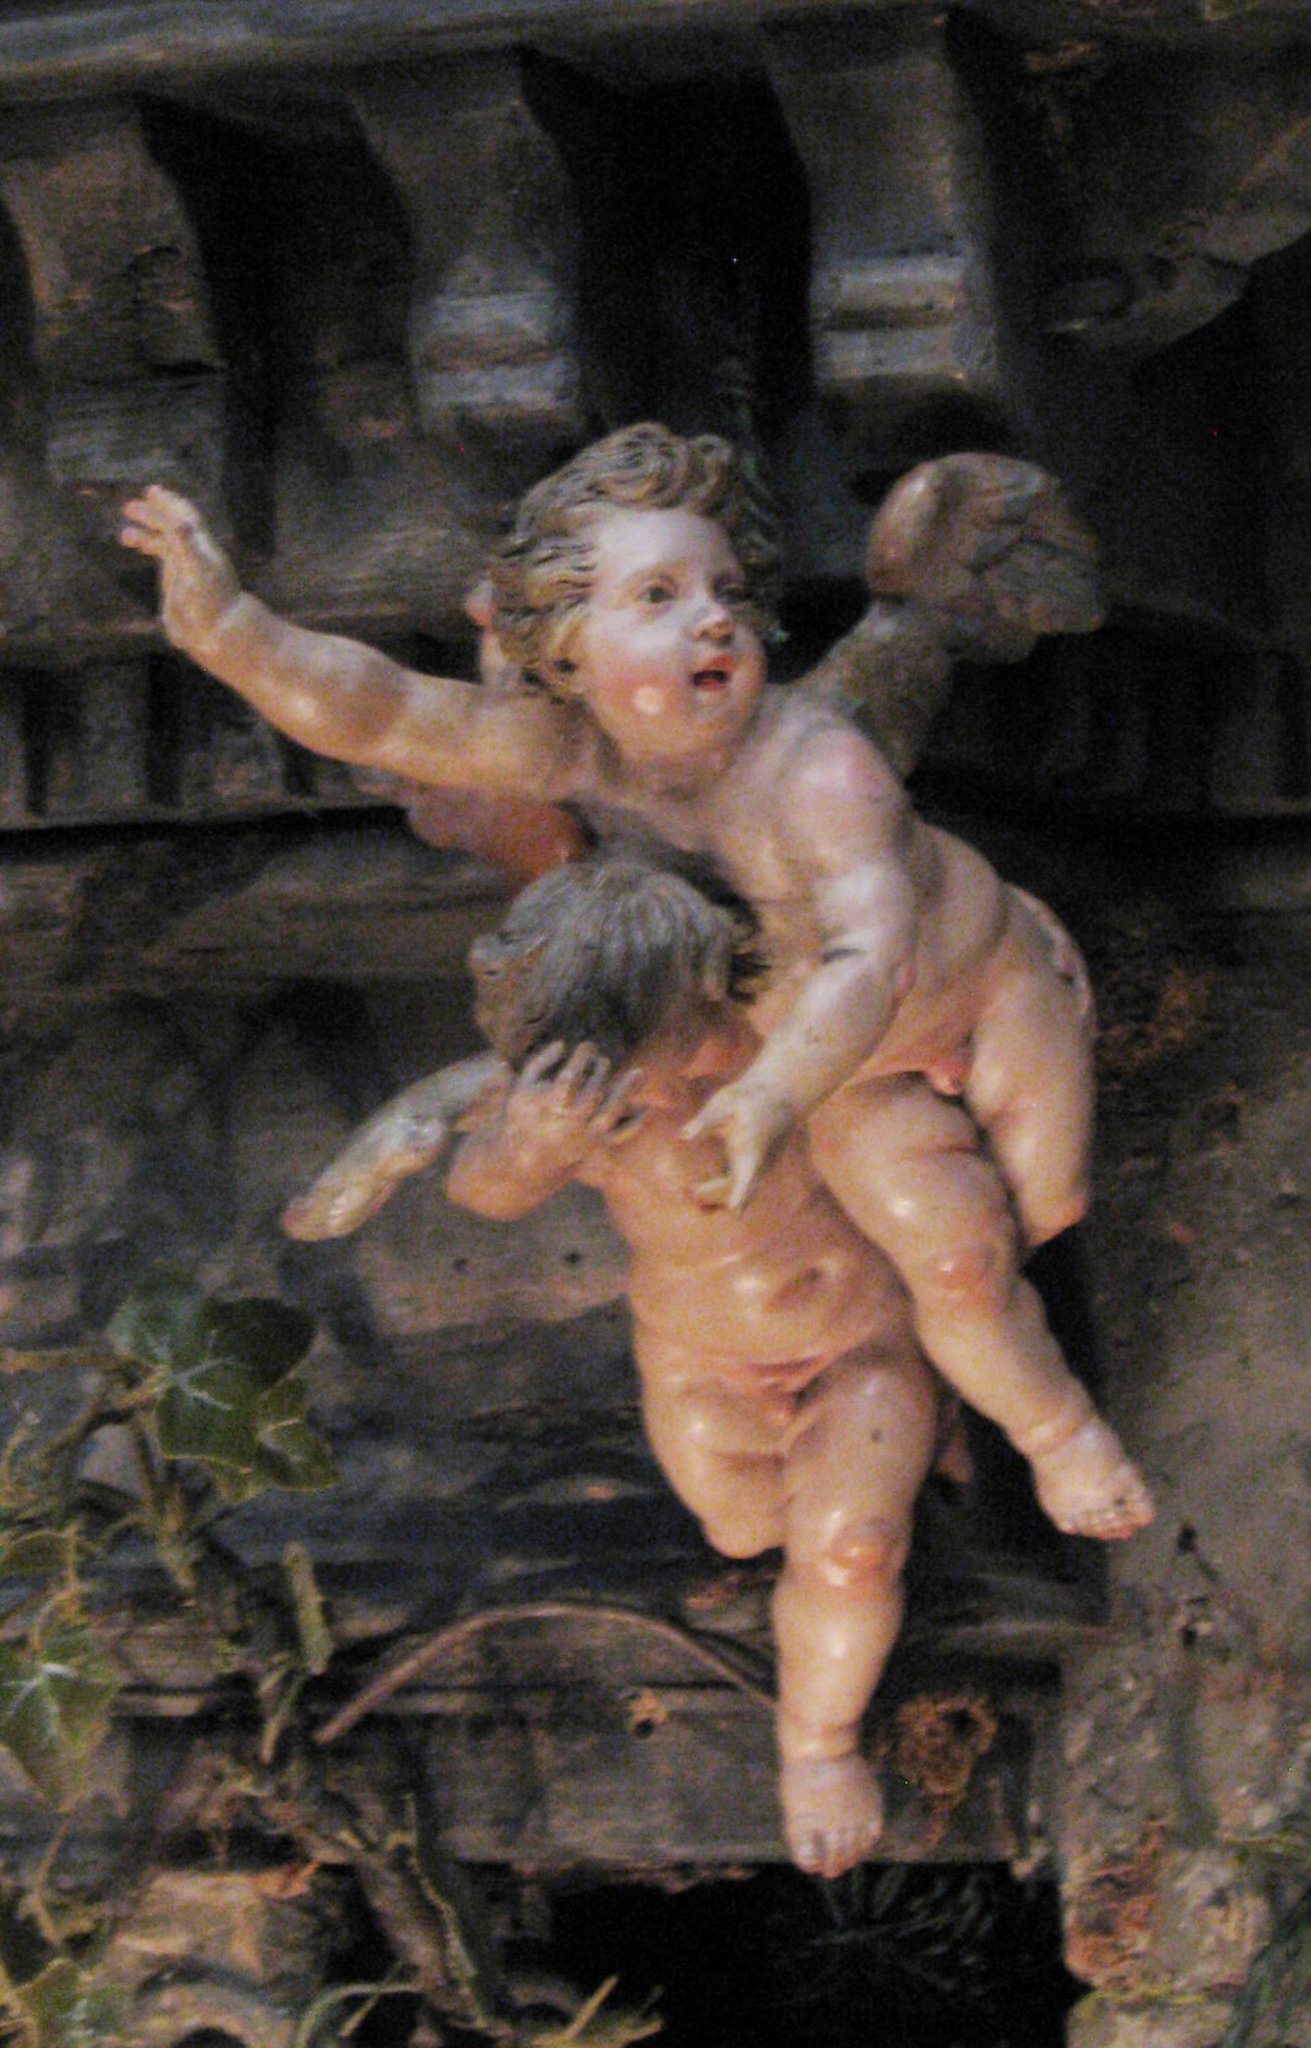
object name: crèche figure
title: Joined pair of cherubs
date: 1751-1800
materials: terracotta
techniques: polychrome